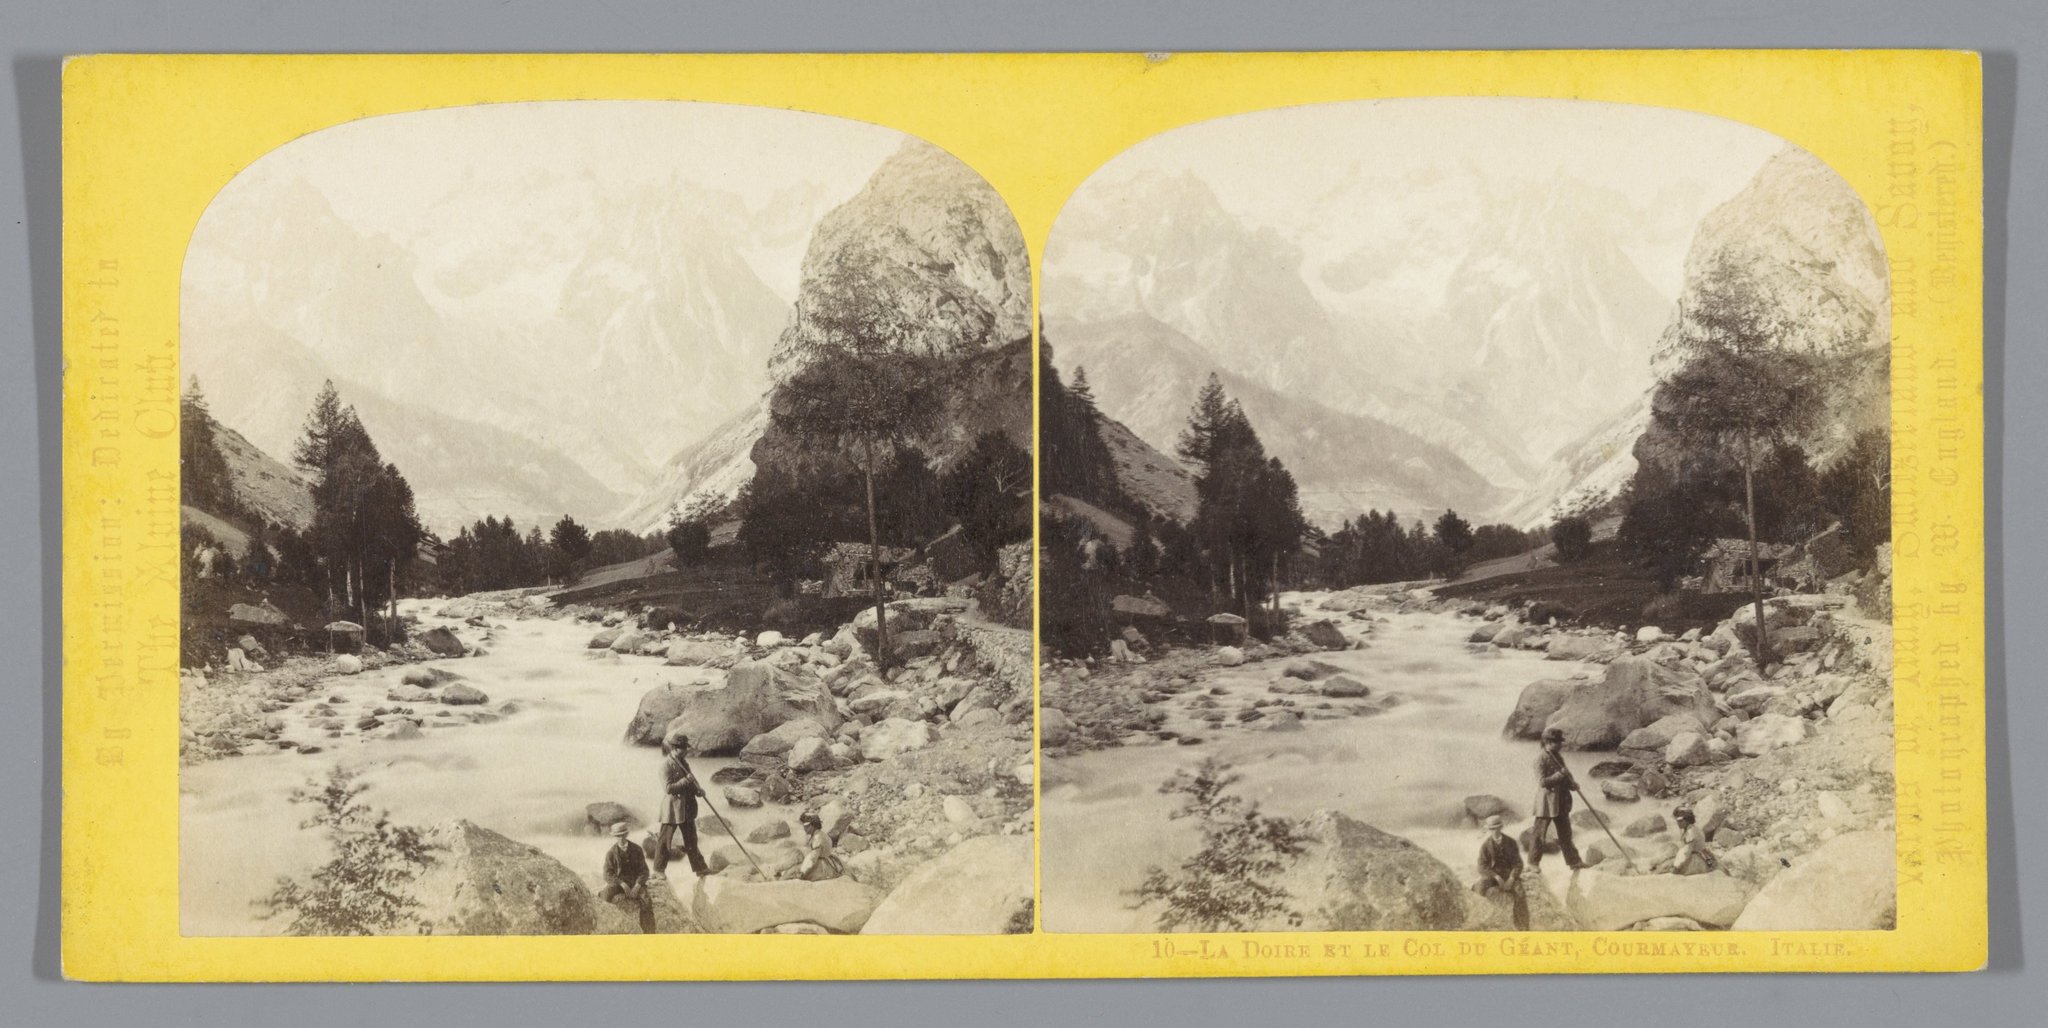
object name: stereograph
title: Views of Italy, Switzerland and Savoy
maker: william england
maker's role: fotograaf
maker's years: 1816-1896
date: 1850-1880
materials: cardboard, photographic support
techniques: albumen print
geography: courmayeur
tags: mountain-range, snow peaks, courmayeur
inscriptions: number: ‘10’, inscription: ‘By Permission: Dedicated to The Alpine Club’, inscription: ‘N10. La Doire et le Col du Géant, Courmayeur. Italie’